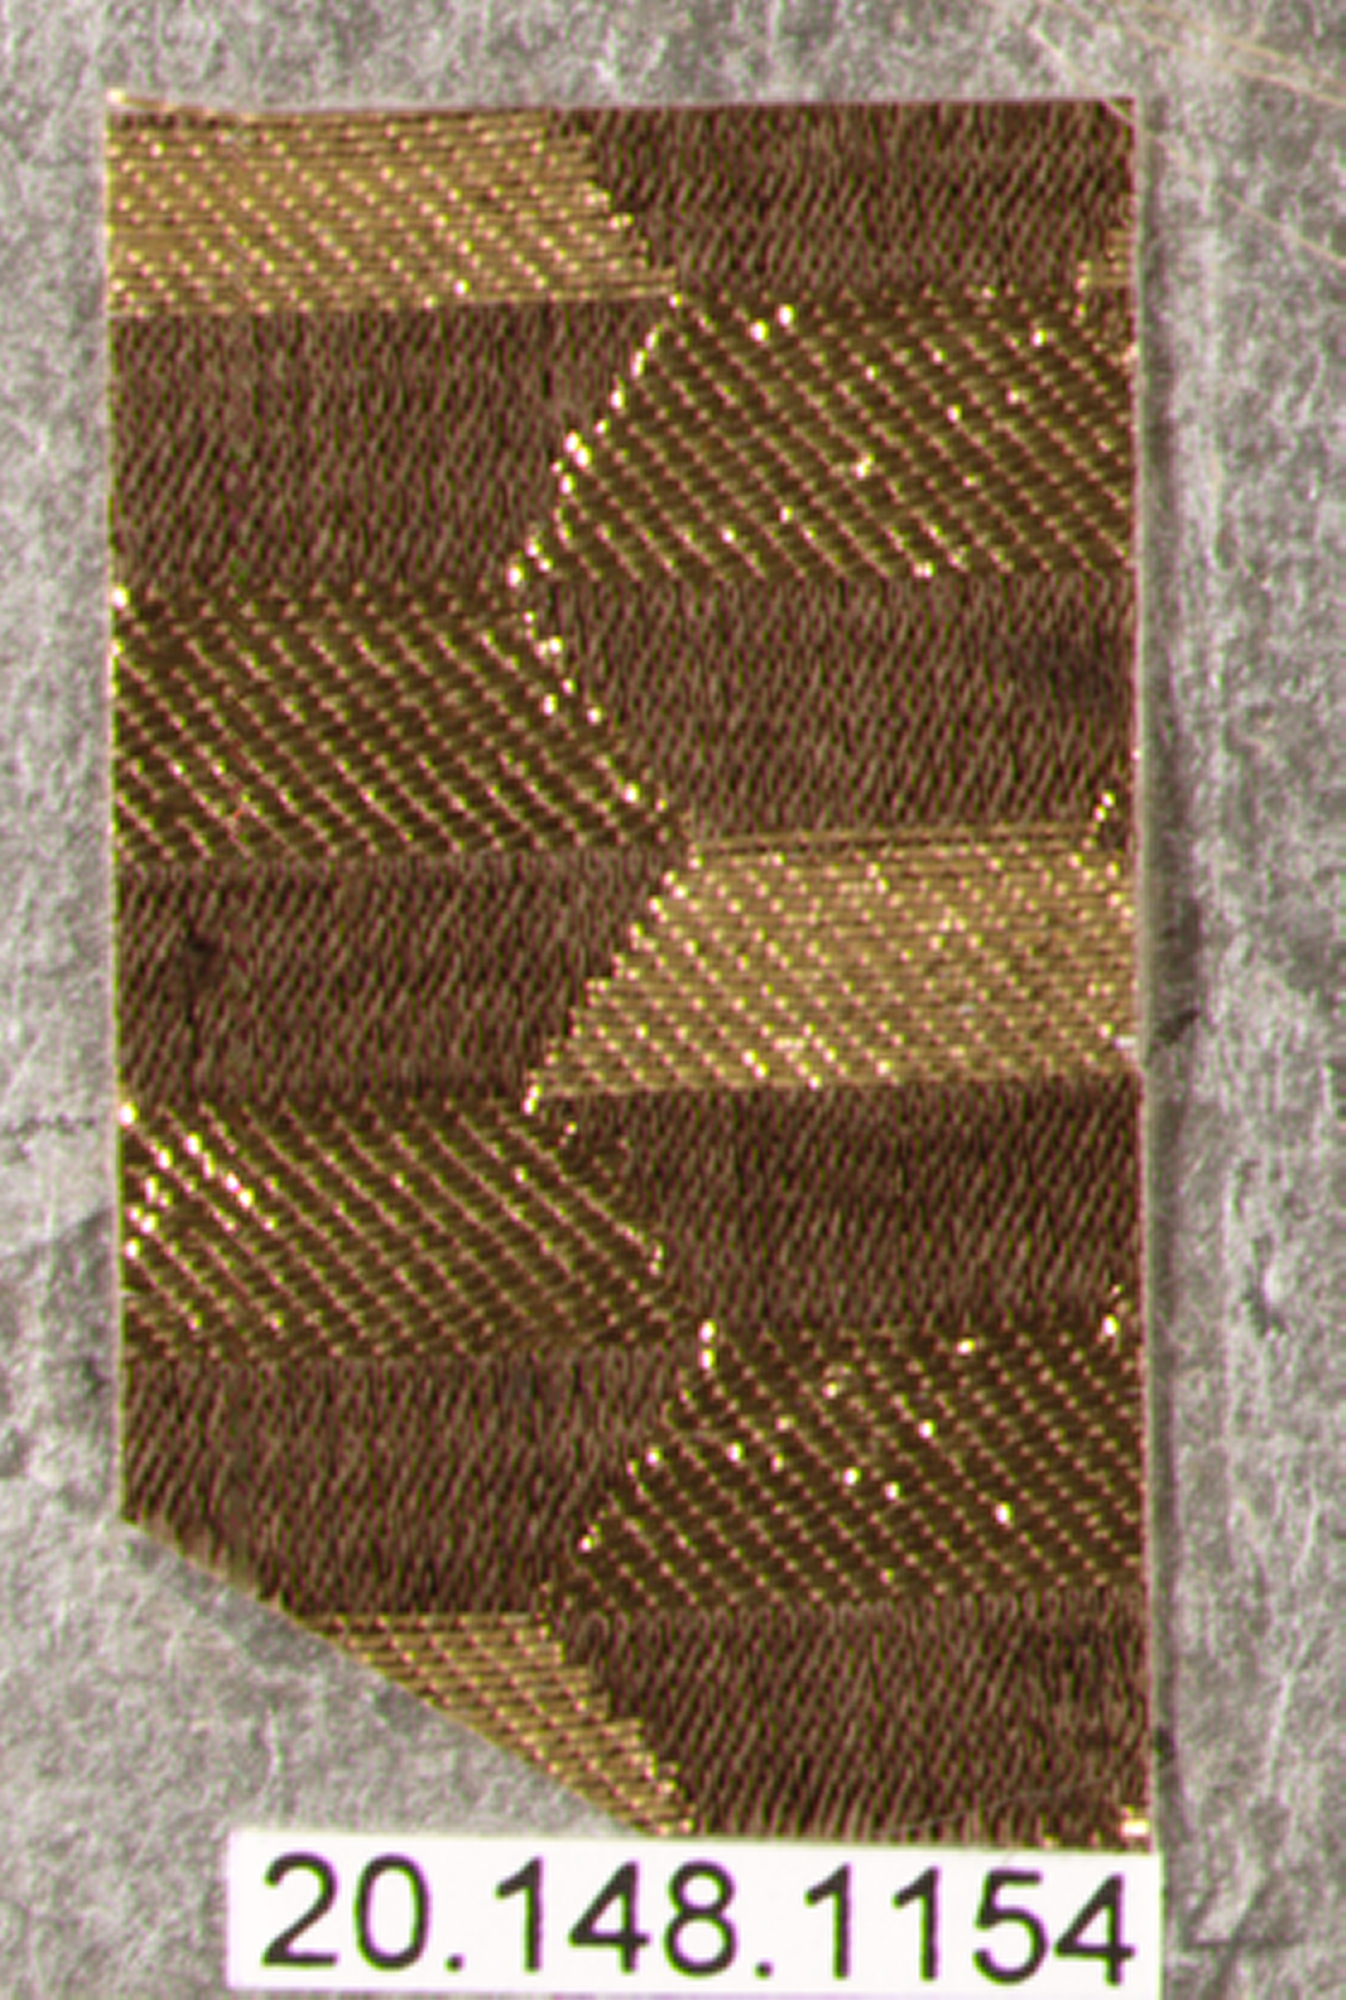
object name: piece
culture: japanese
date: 1801-1900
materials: silk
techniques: compound weave